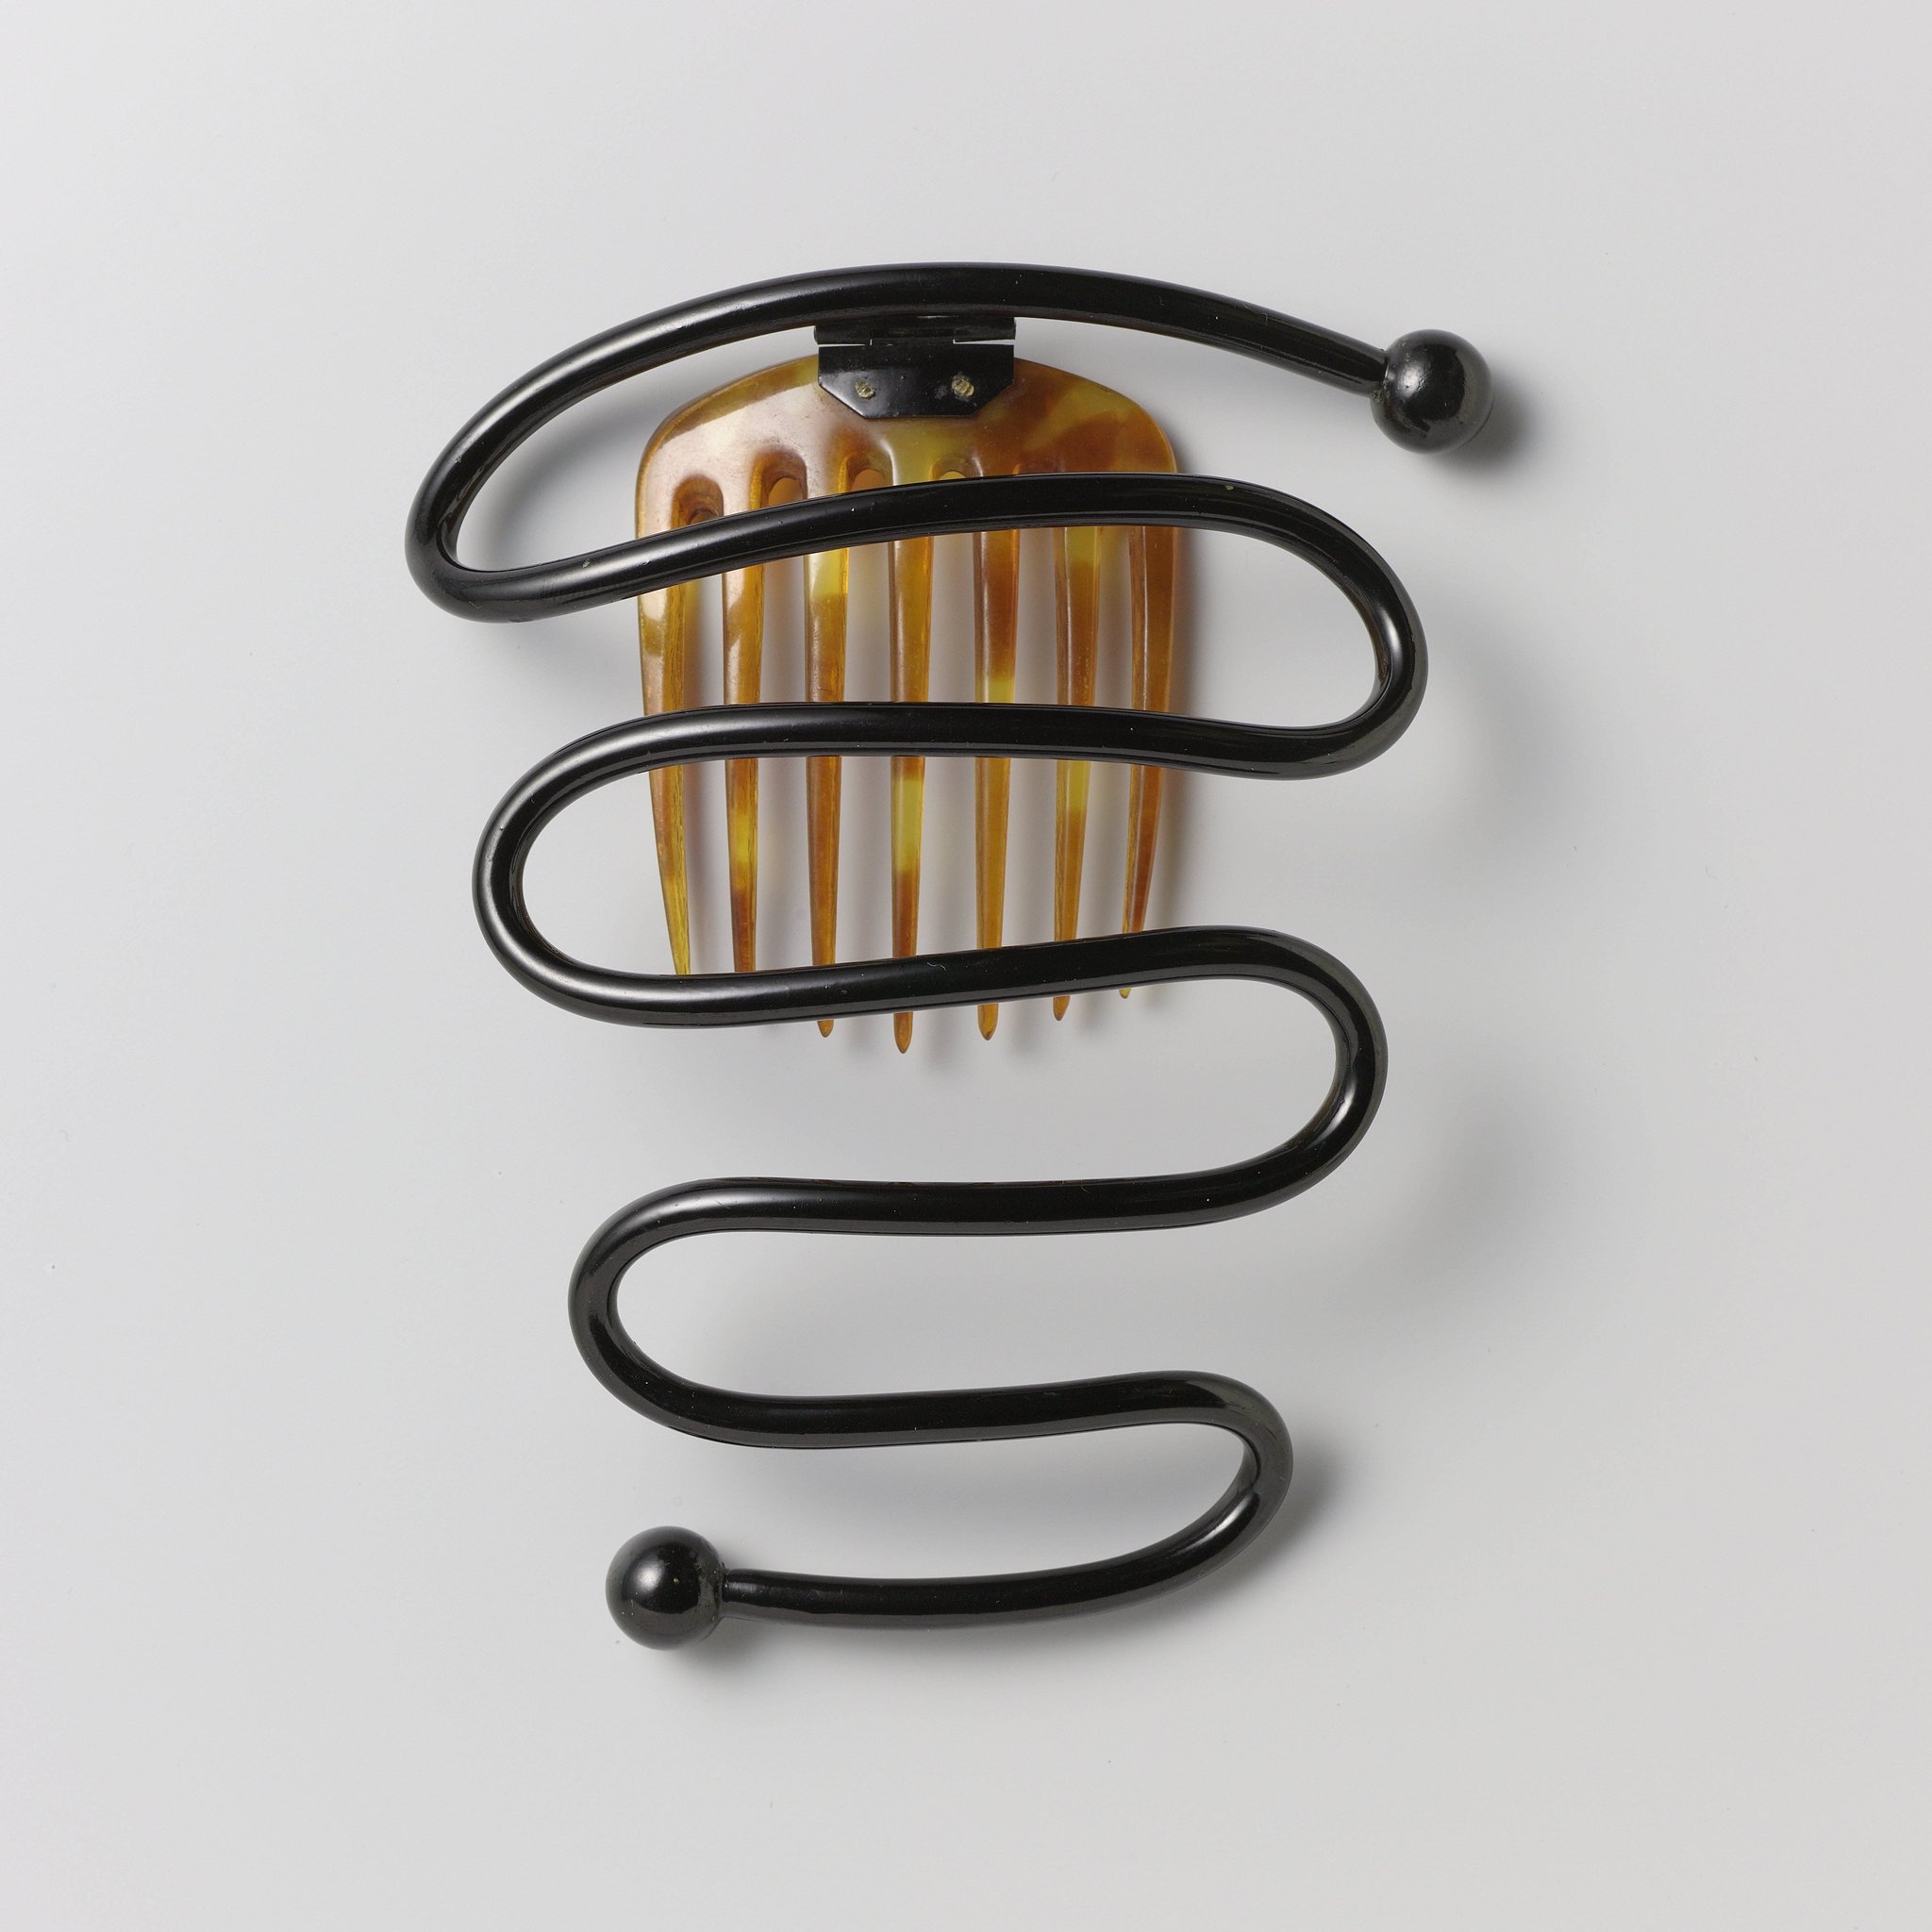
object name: comb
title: Haarkam van blonde imitatie schildpad met een decoratie in de vorm van een slang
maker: Anonymous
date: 1868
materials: celluloid, lacquer, steel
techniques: metalworking, filing, forging, lacquer, polish, pressing, sawing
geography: france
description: Haarkam van schildpad. Het montuur van gebogen en gelakt staal eindigt aan beide zijden in een bol. Deze haarkam lijkt met zijn eenvoudige en krachtige lijnen helemaal aan te sluiten bij de neoclassicistische mode aan het begin van de 19de eeuw. In die tijd werden de haarkammen echter merendeels boven op het hoofd gedragen. Deze kam is daarentegen juist bedoeld om boven in een lange wrong of knot te steken. Hij zou dus net zo goed van veel later datum kunnen zijn.